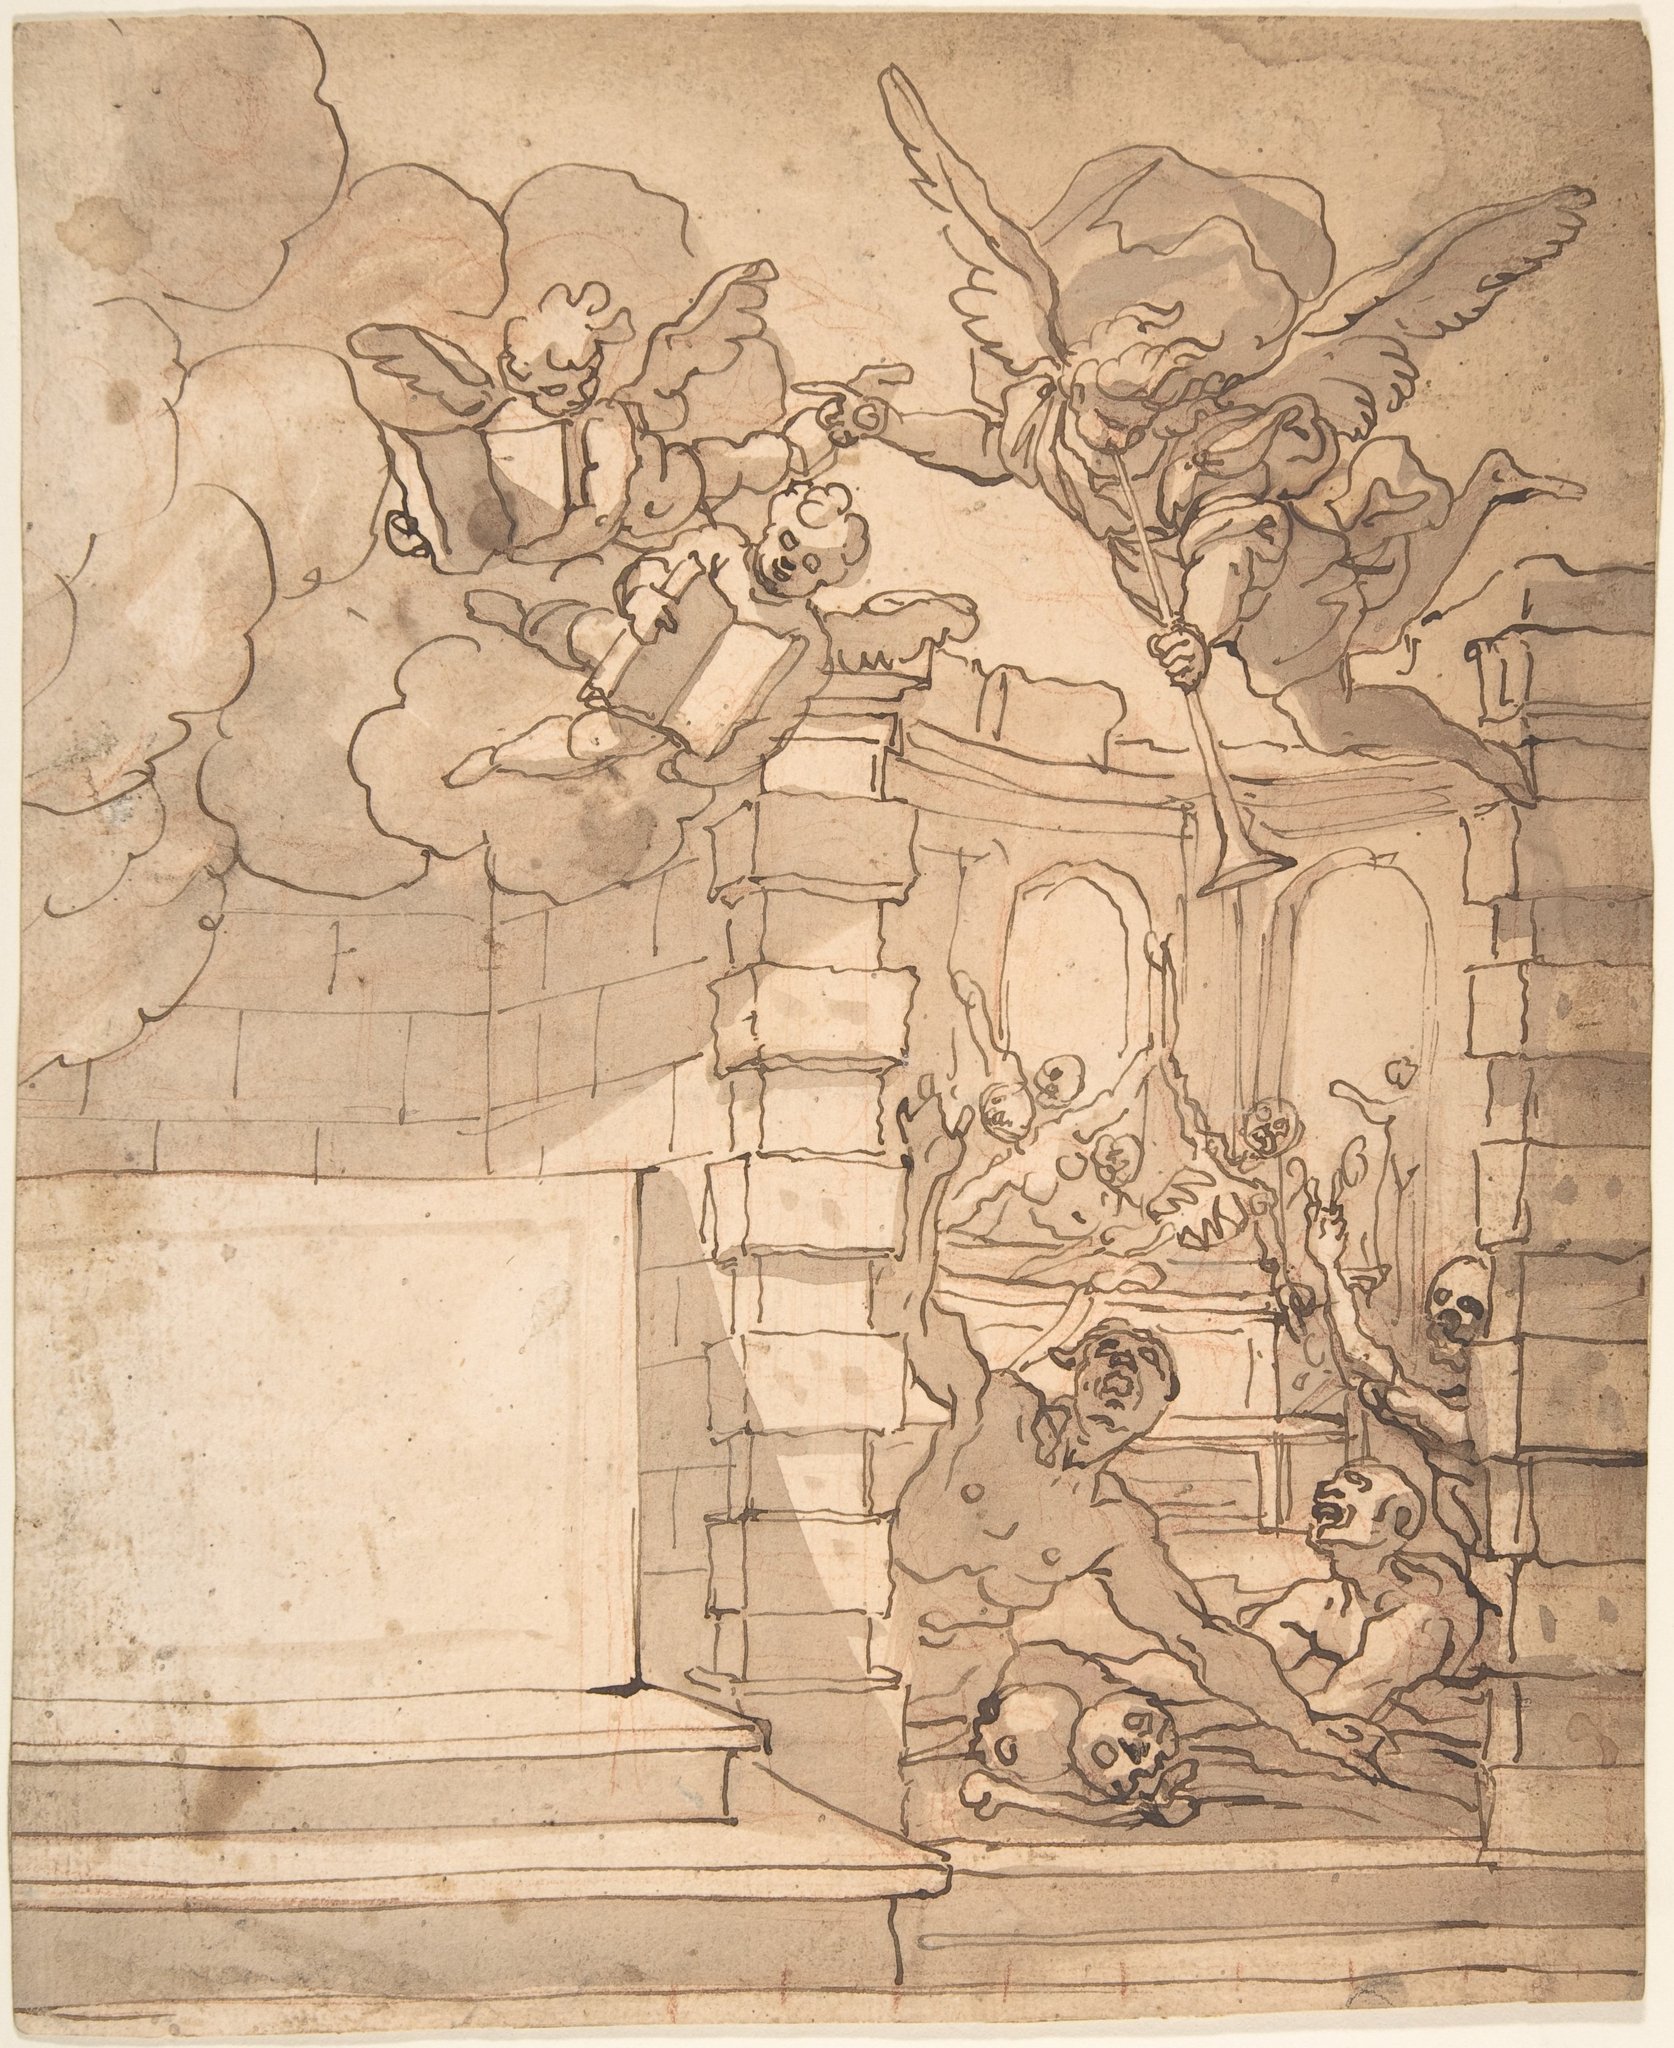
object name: drawing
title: Design for a Title Page - Angel of the Resurrection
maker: anonymous, italian, 17th century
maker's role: artist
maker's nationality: italian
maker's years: 1600-1700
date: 1601-1700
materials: chalk, ink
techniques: brush, pen, wash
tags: human figures,angels